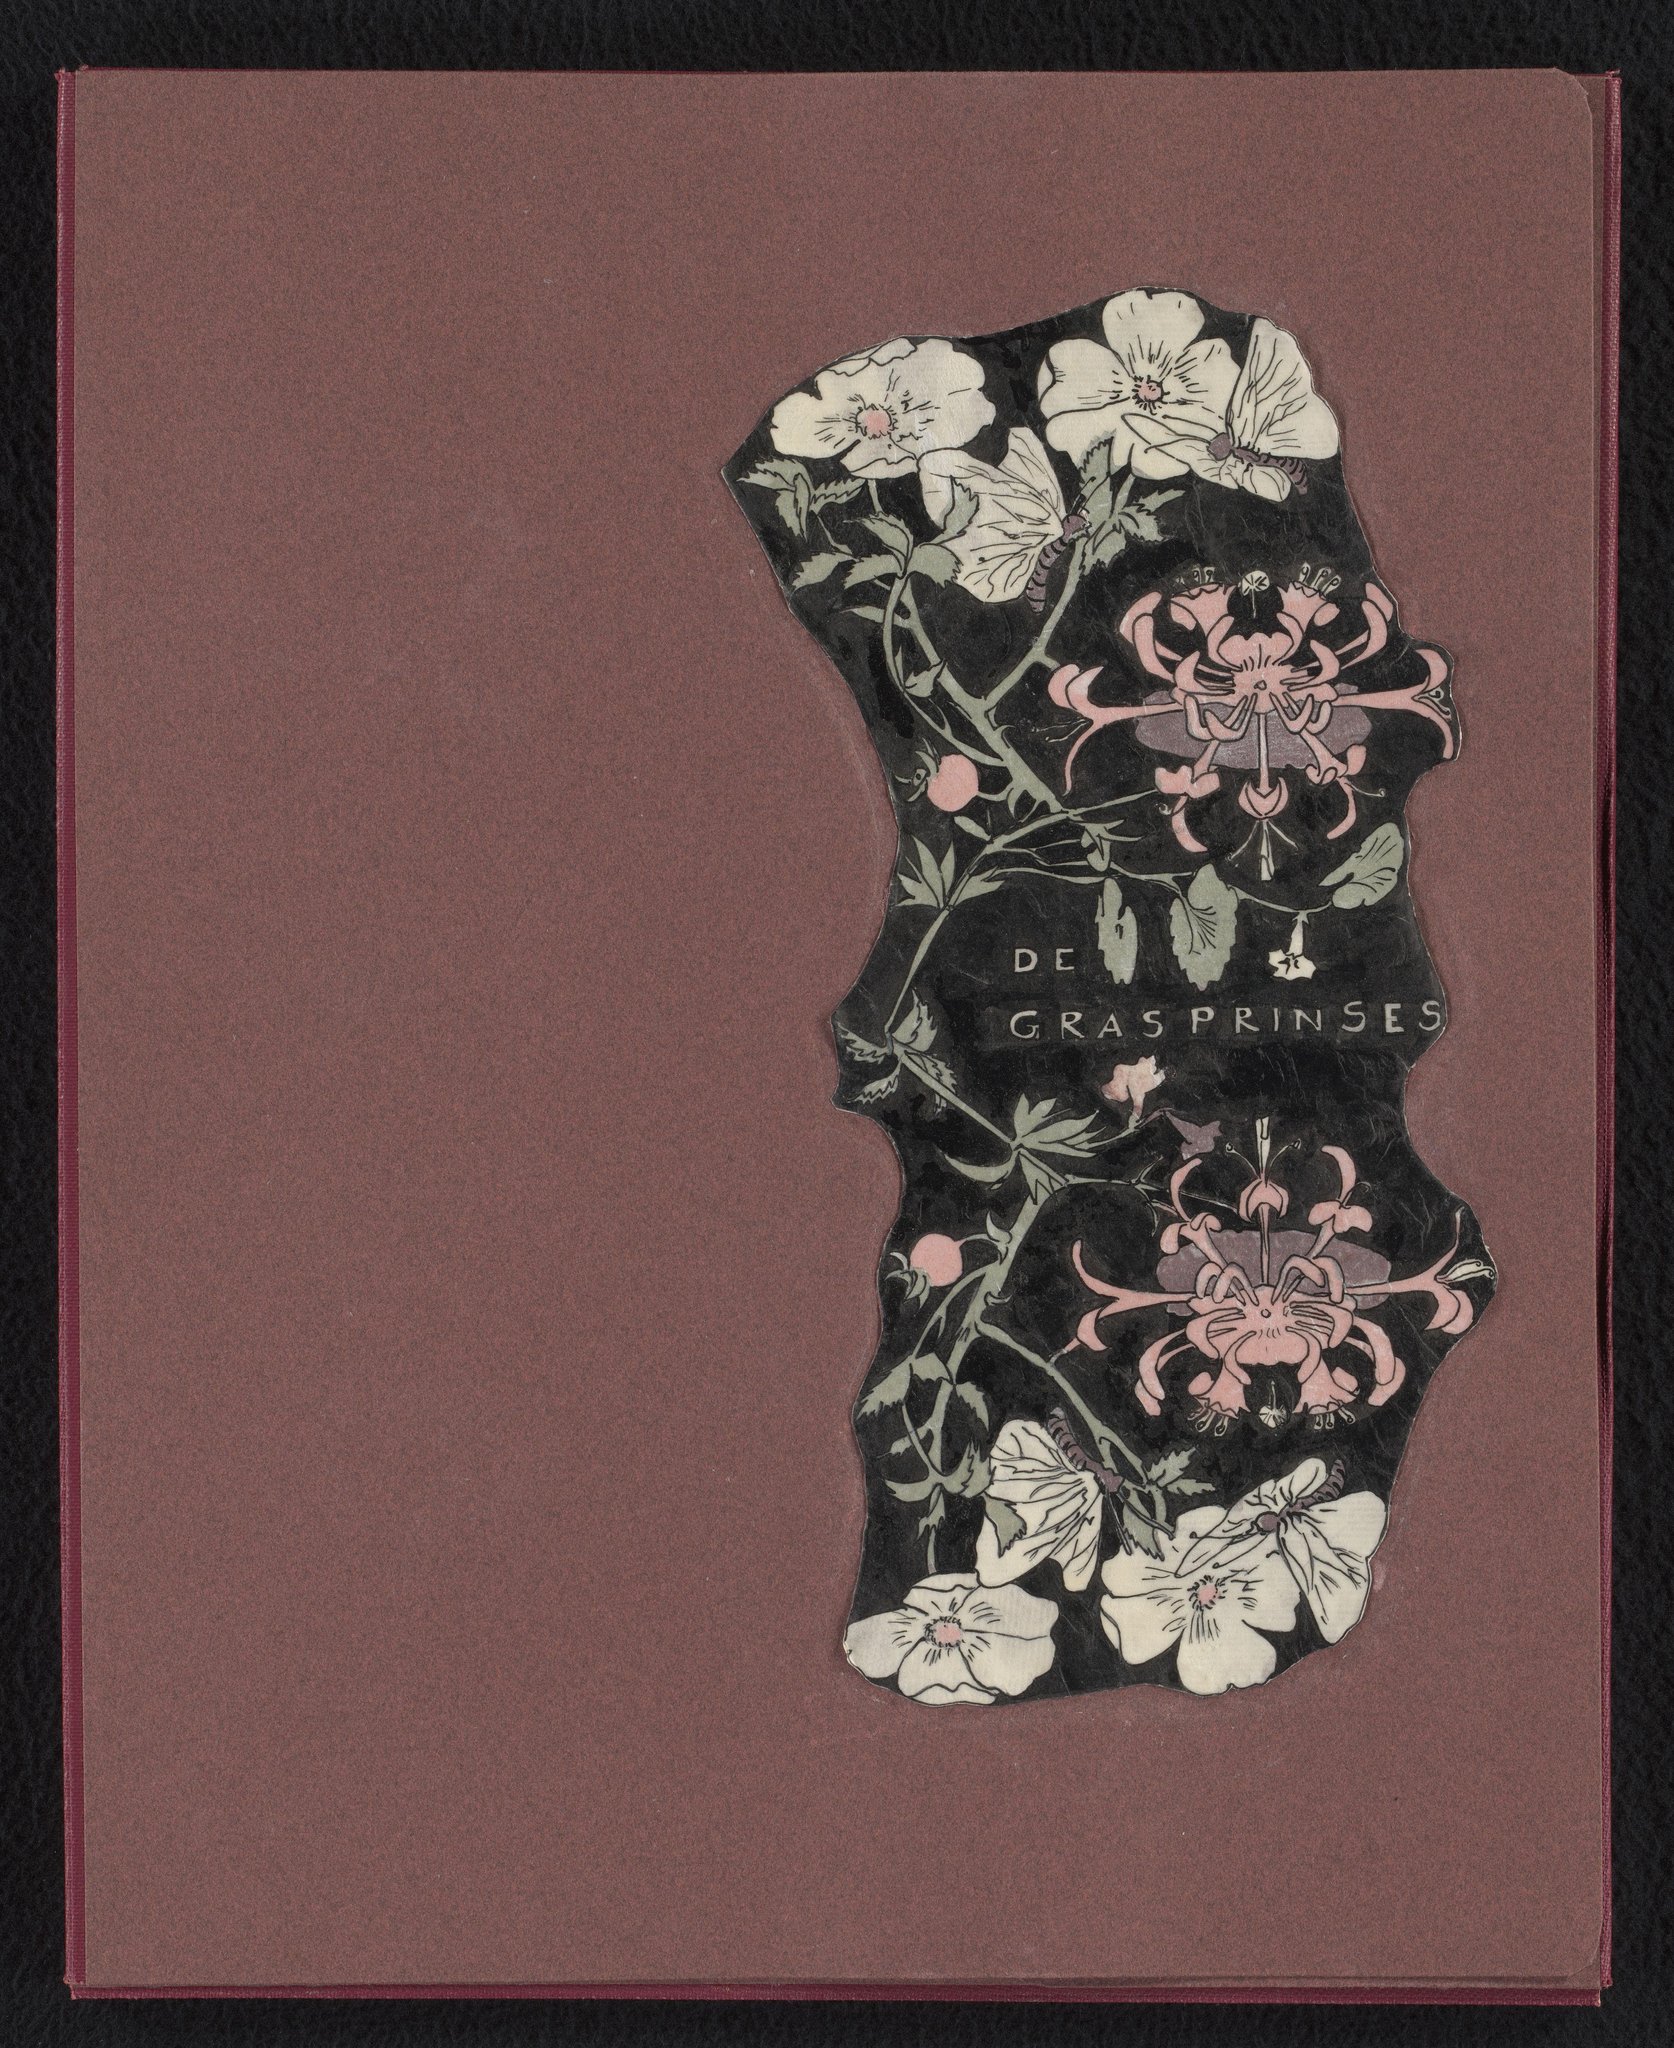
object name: wrapper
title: Omslag voor acht tekeningen met ontwerpen voor boekillustraties en één document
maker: edzard koning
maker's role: draughtsman, print maker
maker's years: 1869-1954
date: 1879-1954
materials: ink, linen, paper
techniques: pen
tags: (koning, de grasprinses) specific works of literature (with author, title)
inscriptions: collector's mark: Lugt 2228